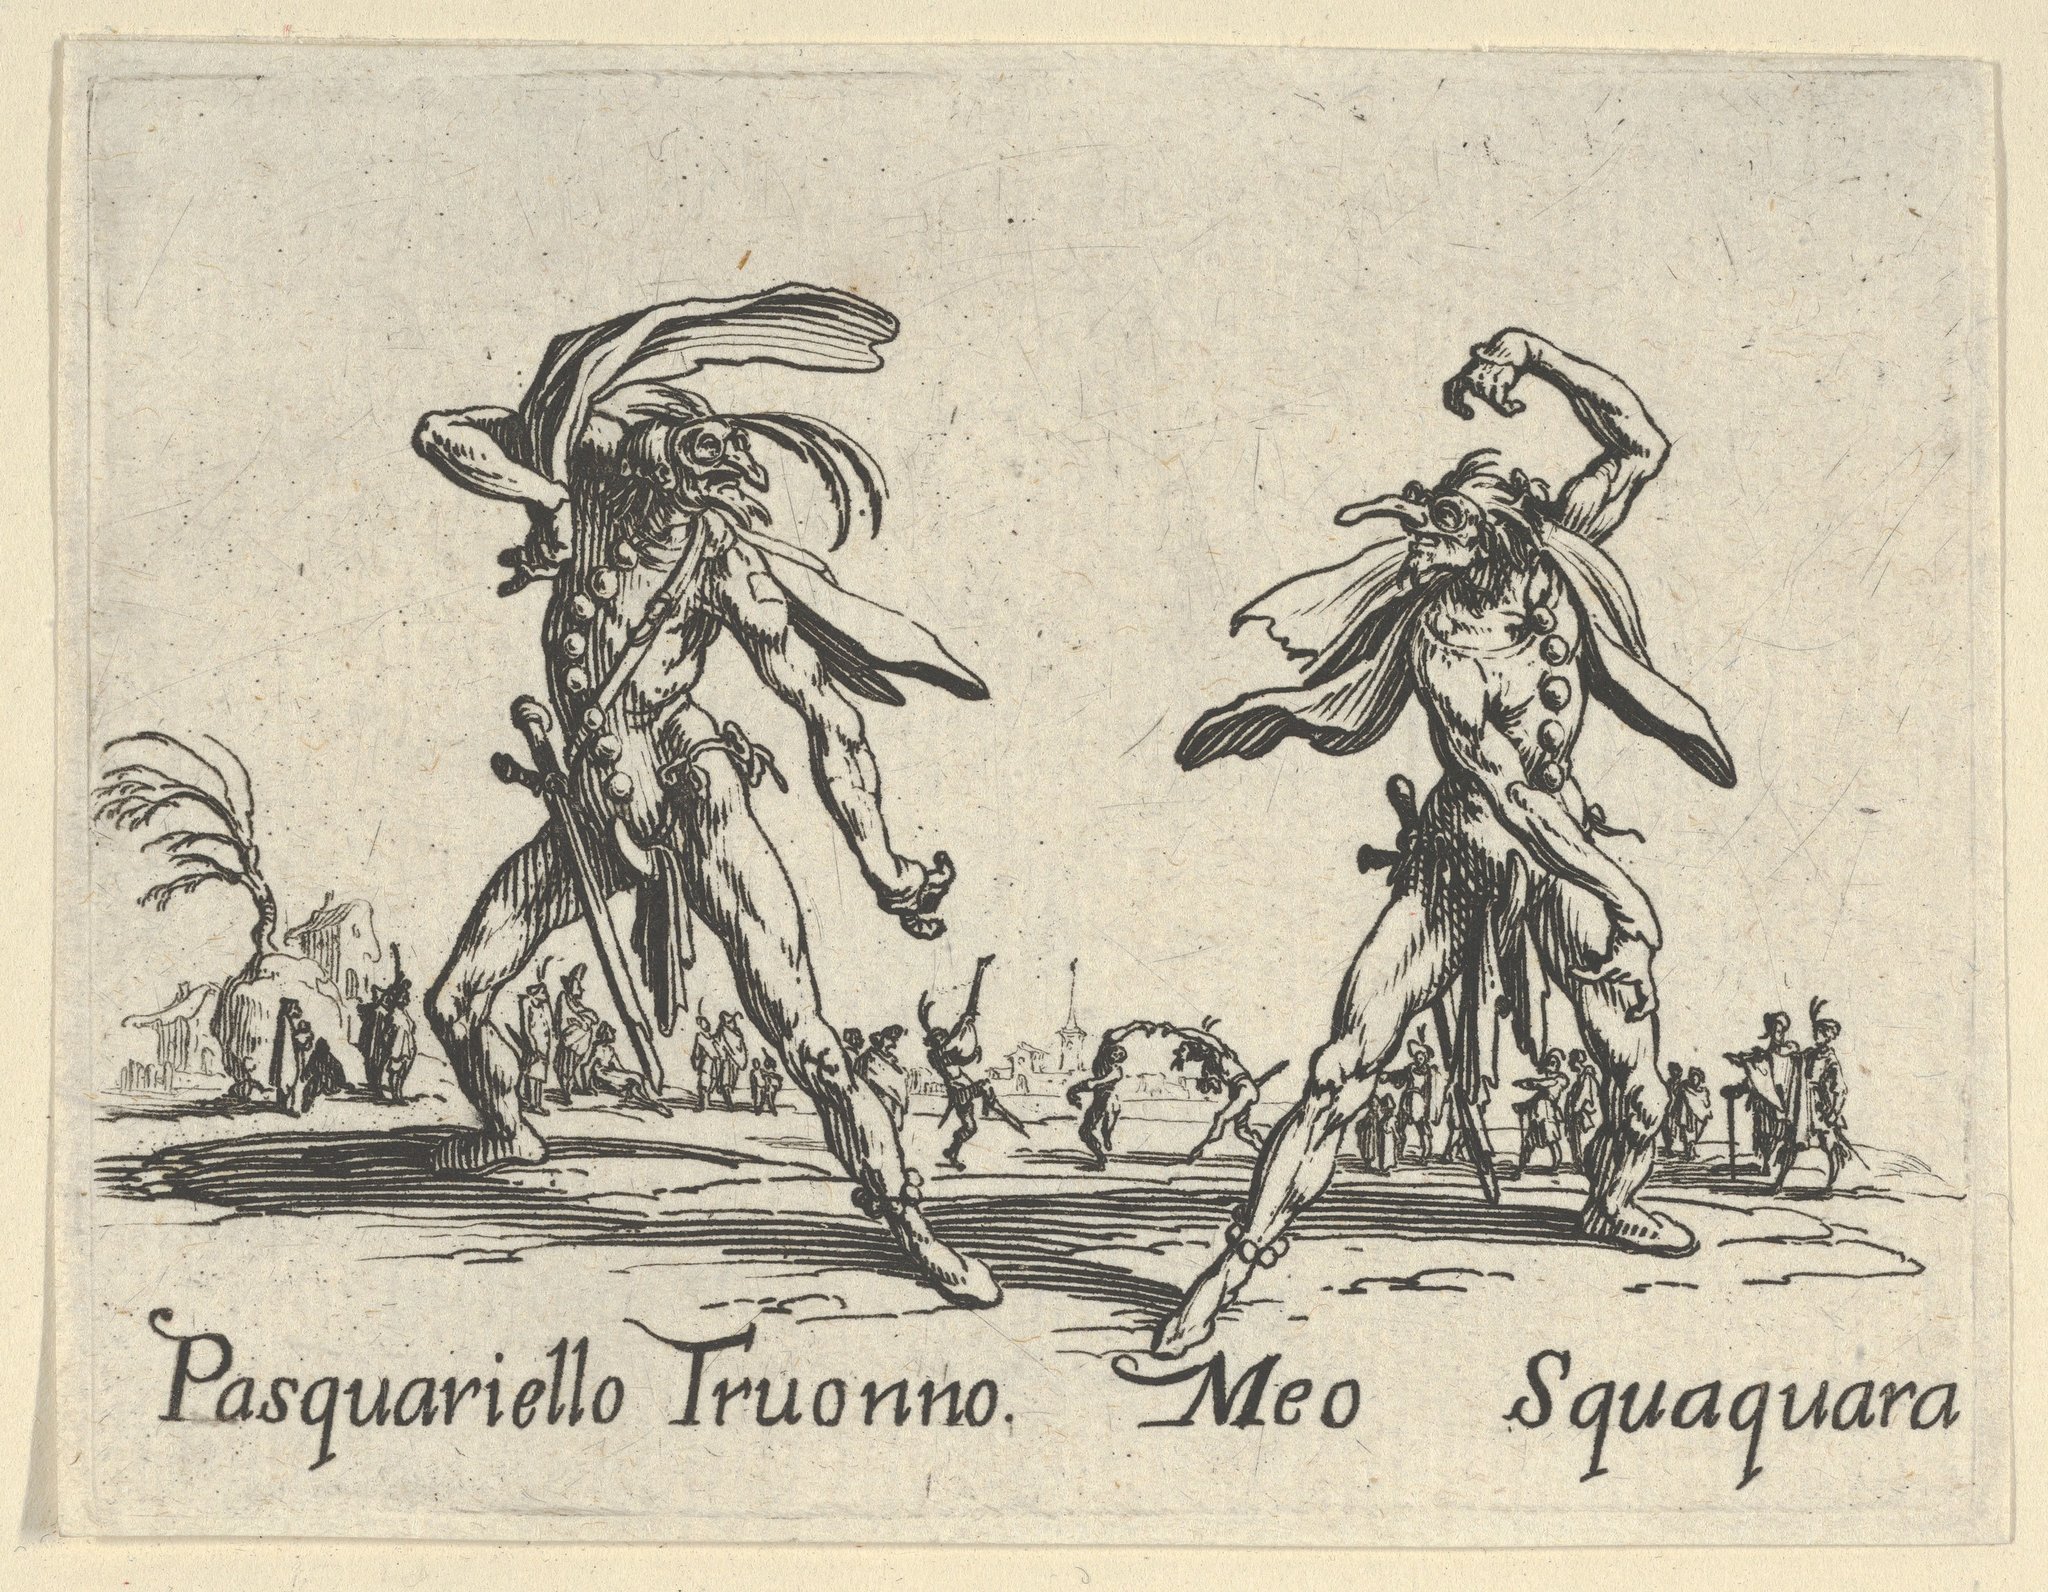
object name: print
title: Pasquariello Truonno - Meo Squaquara, from "Balli di Sfessania" (Dance of Sfessania)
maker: jacques callot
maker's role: artist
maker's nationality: french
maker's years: 1592-1635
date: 1622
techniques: etching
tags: men